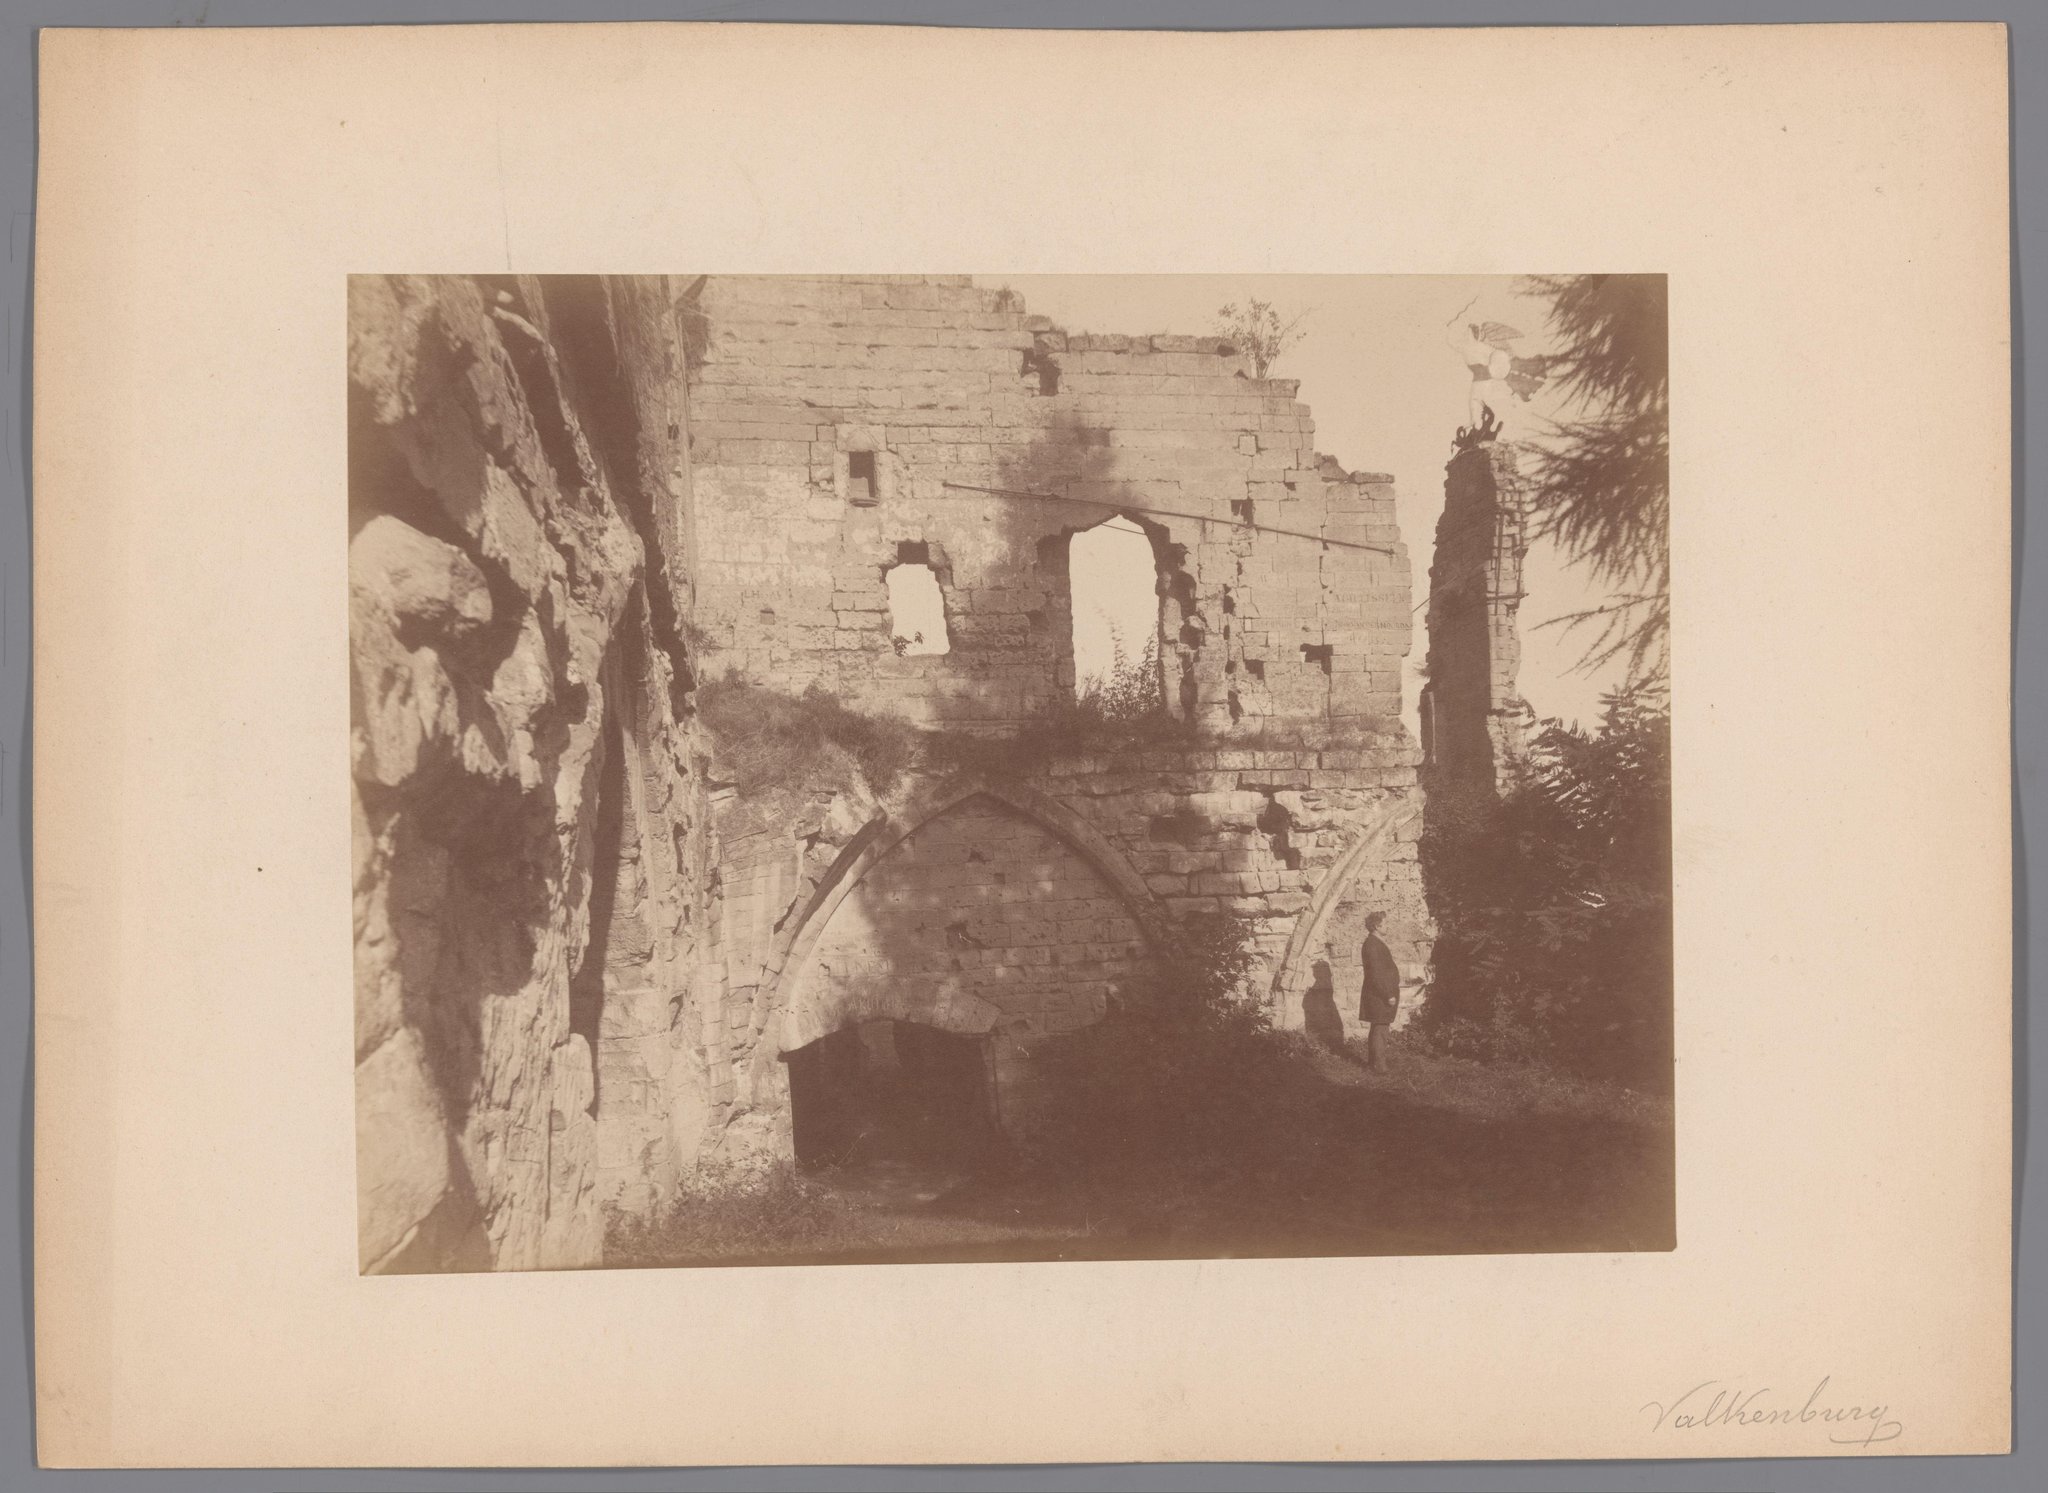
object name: photograph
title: Ridderzaal van de kasteelruïne te Valkenburg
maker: anoniem (monumentenzorg)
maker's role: fotograaf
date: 1890-1920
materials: cardboard, photographic support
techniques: albumen print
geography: valkenburg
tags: ruin of a dwelling, house, castle, etc.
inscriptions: annotation: ‘Valkenburg’, annotation: ‘Ruïne te Valkenburg/ Ridderzaal’